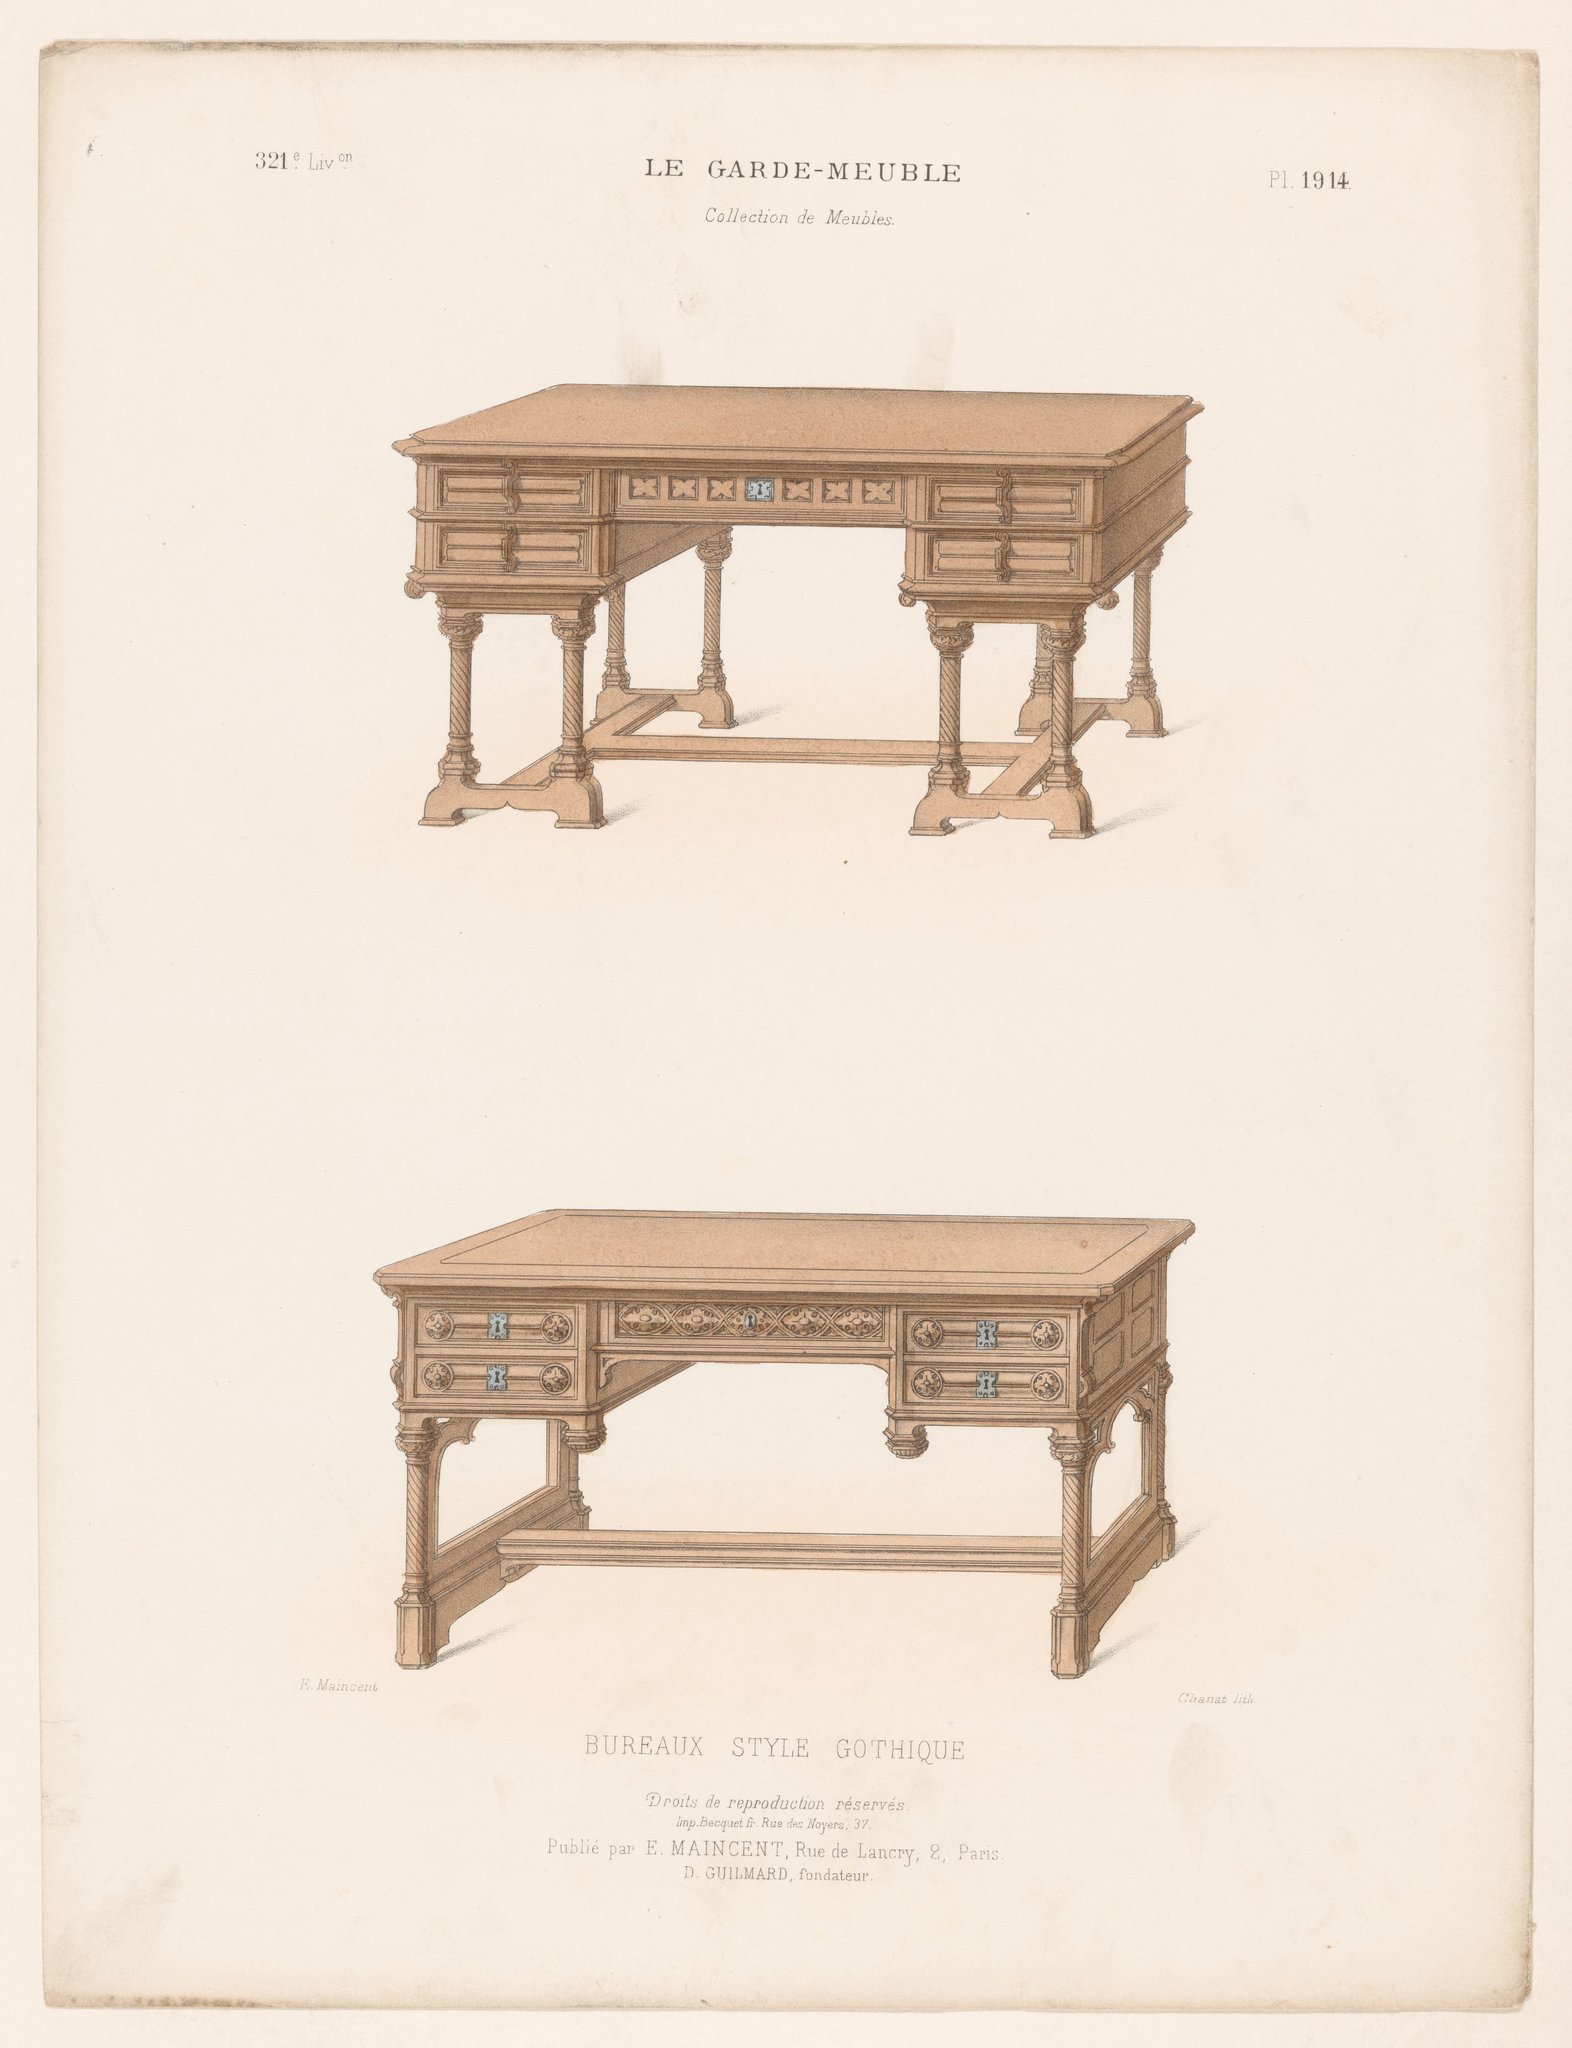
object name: print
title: Le garde-meuble / Collection de Meubles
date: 1885-1895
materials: paper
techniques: hand coloring, lithograph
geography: paris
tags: writing-table, writing-desk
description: Ieder Livraison in de serie Le Garde-Meuble bevat negen platen: drie 'sièges' (zitmeubels), drie 'meubles' (diverse meubels zoals tafels en kasten) en drie 'tentures' (gordijnen en draperieën).